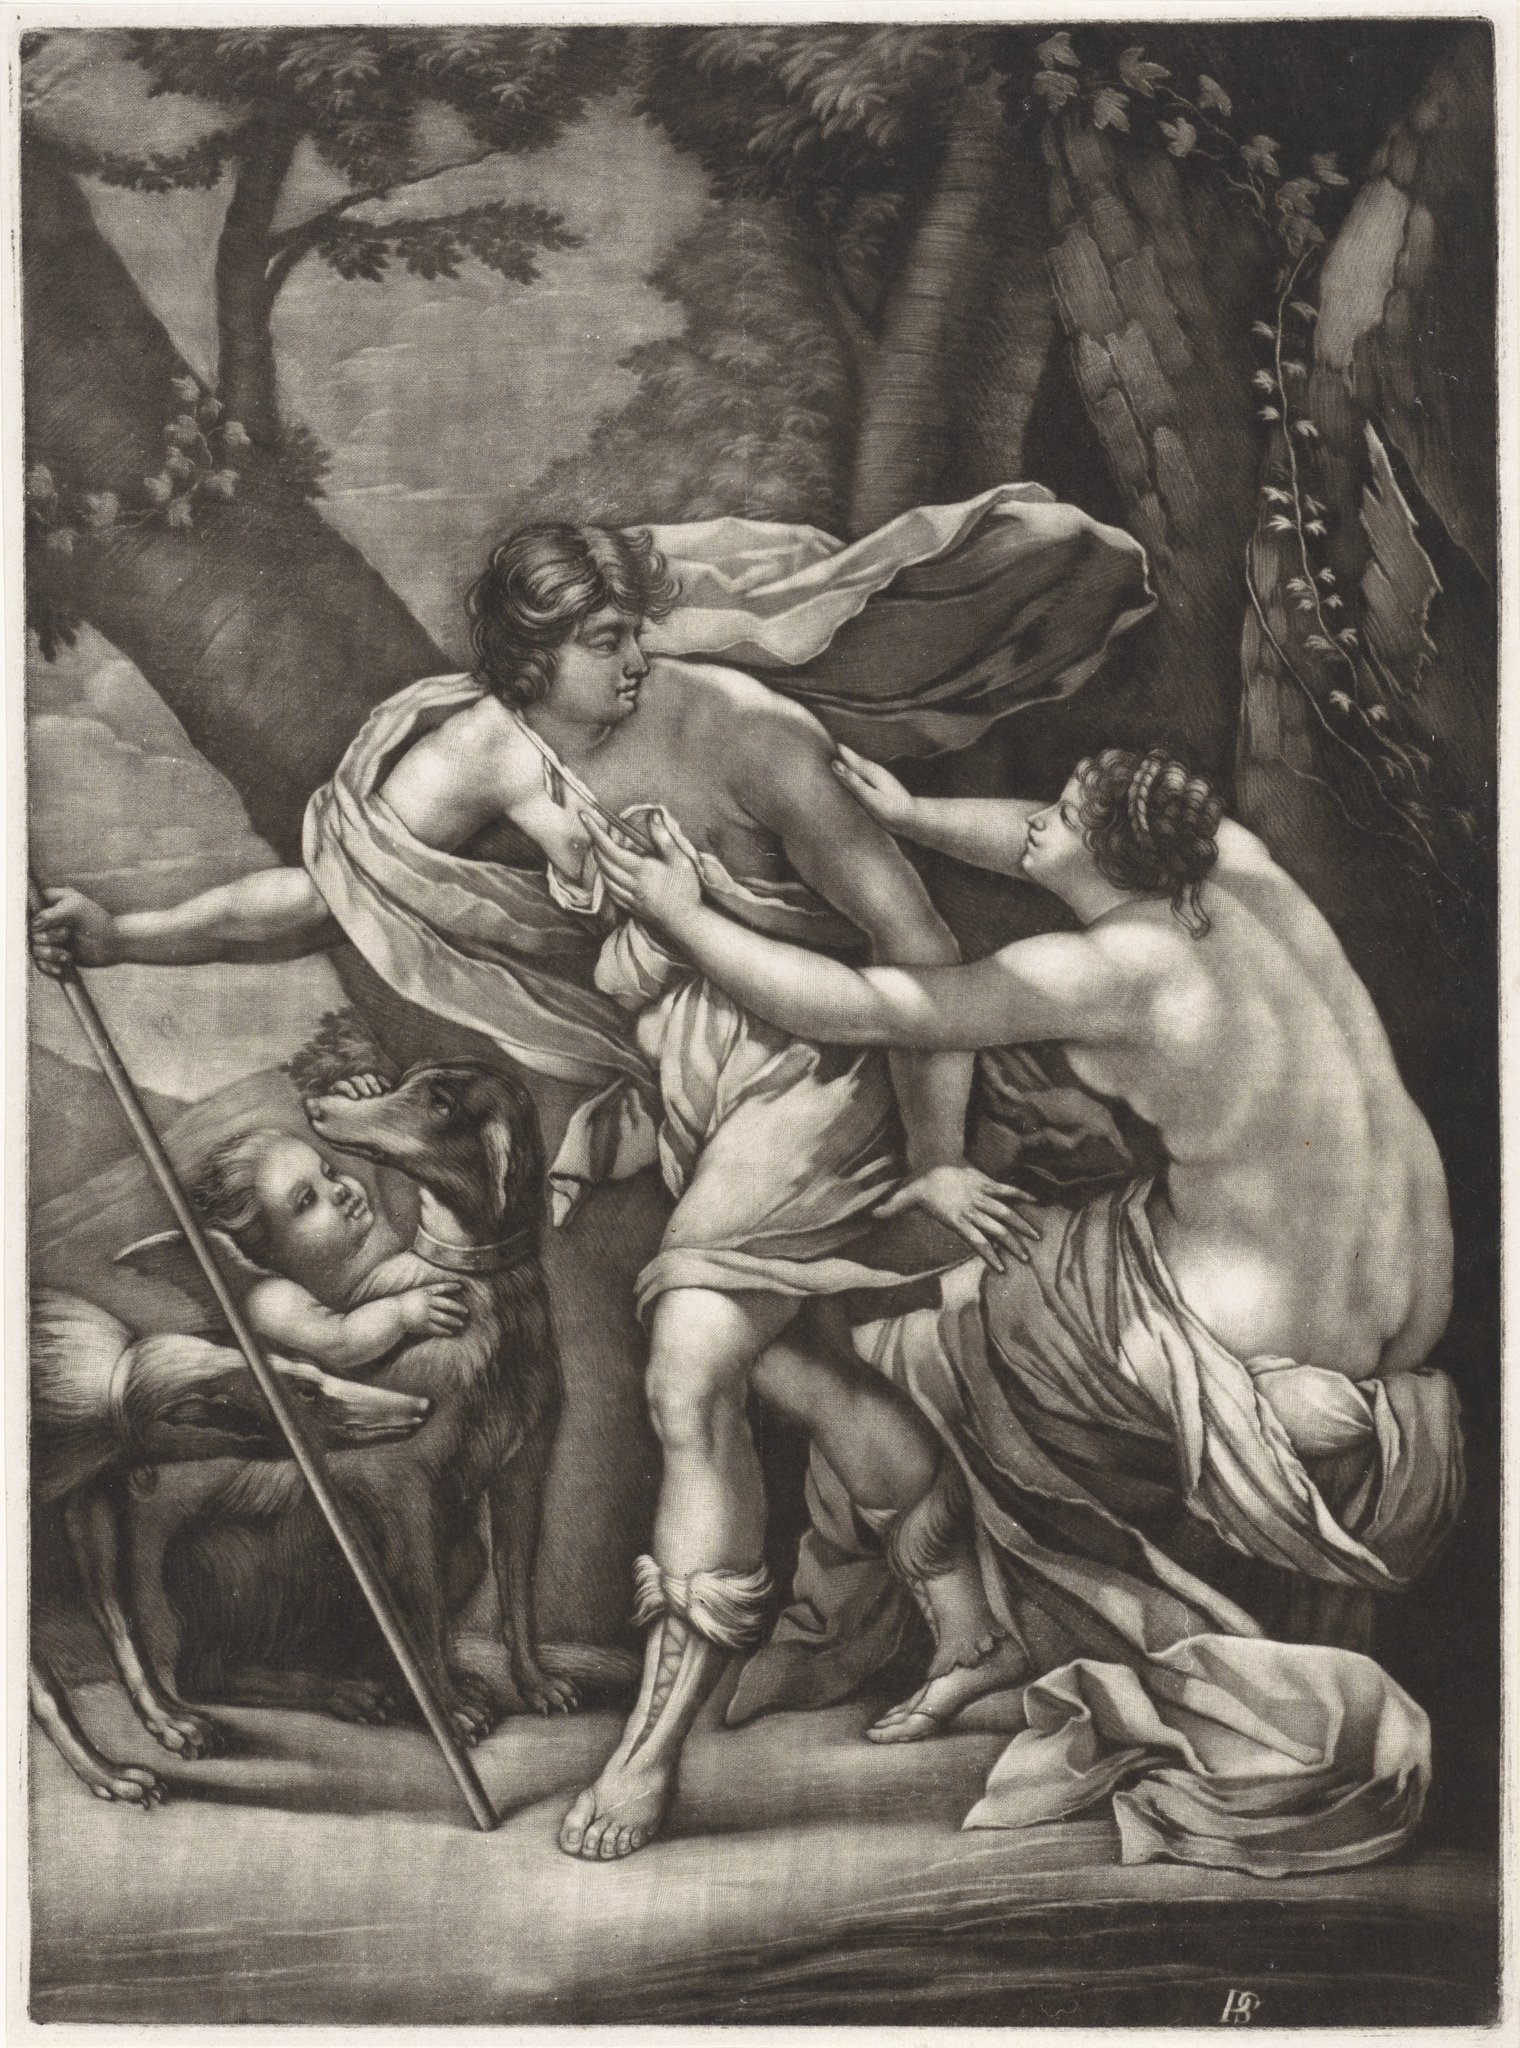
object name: print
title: Venus weerhoudt Adonis van de jacht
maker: pieter schenk (i)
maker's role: print maker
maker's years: 1660-1711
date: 1670-1713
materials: paper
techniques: mezzotint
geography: amsterdam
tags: venus and adonis as lovers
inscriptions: collector's mark: Lugt 2228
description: Venus en Amor proberen Adonis te beletten om op jacht te gaan. Adonis gaat echter toch jagen; hij draagt een lans en voor hem zitten zijn twee jachthonden.